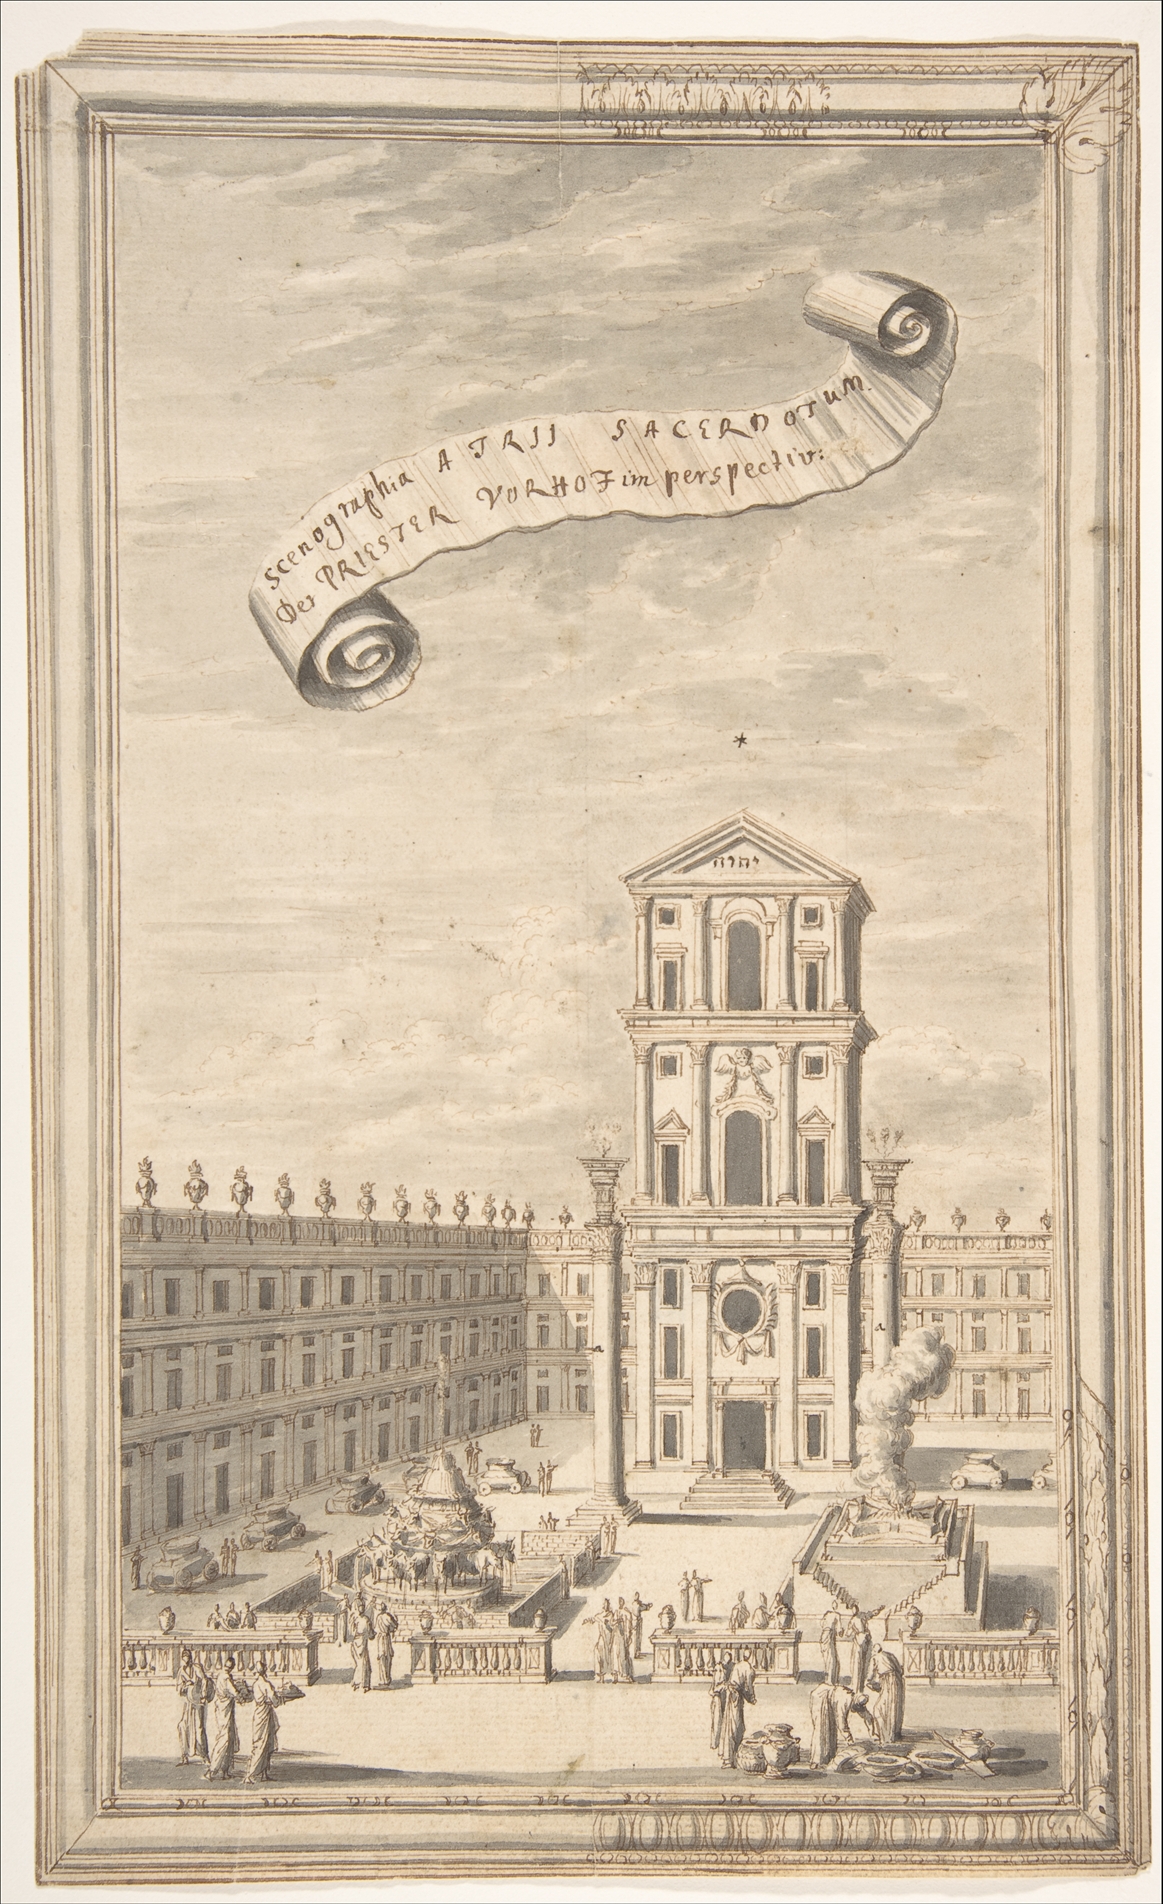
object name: drawing ornament architecture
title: The Sacerdotal Atrium in Perspective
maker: johann melchior füssli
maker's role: artist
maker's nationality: swiss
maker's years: 1677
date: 1667-1733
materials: ink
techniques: brush, pen, wash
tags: human figures,buildings